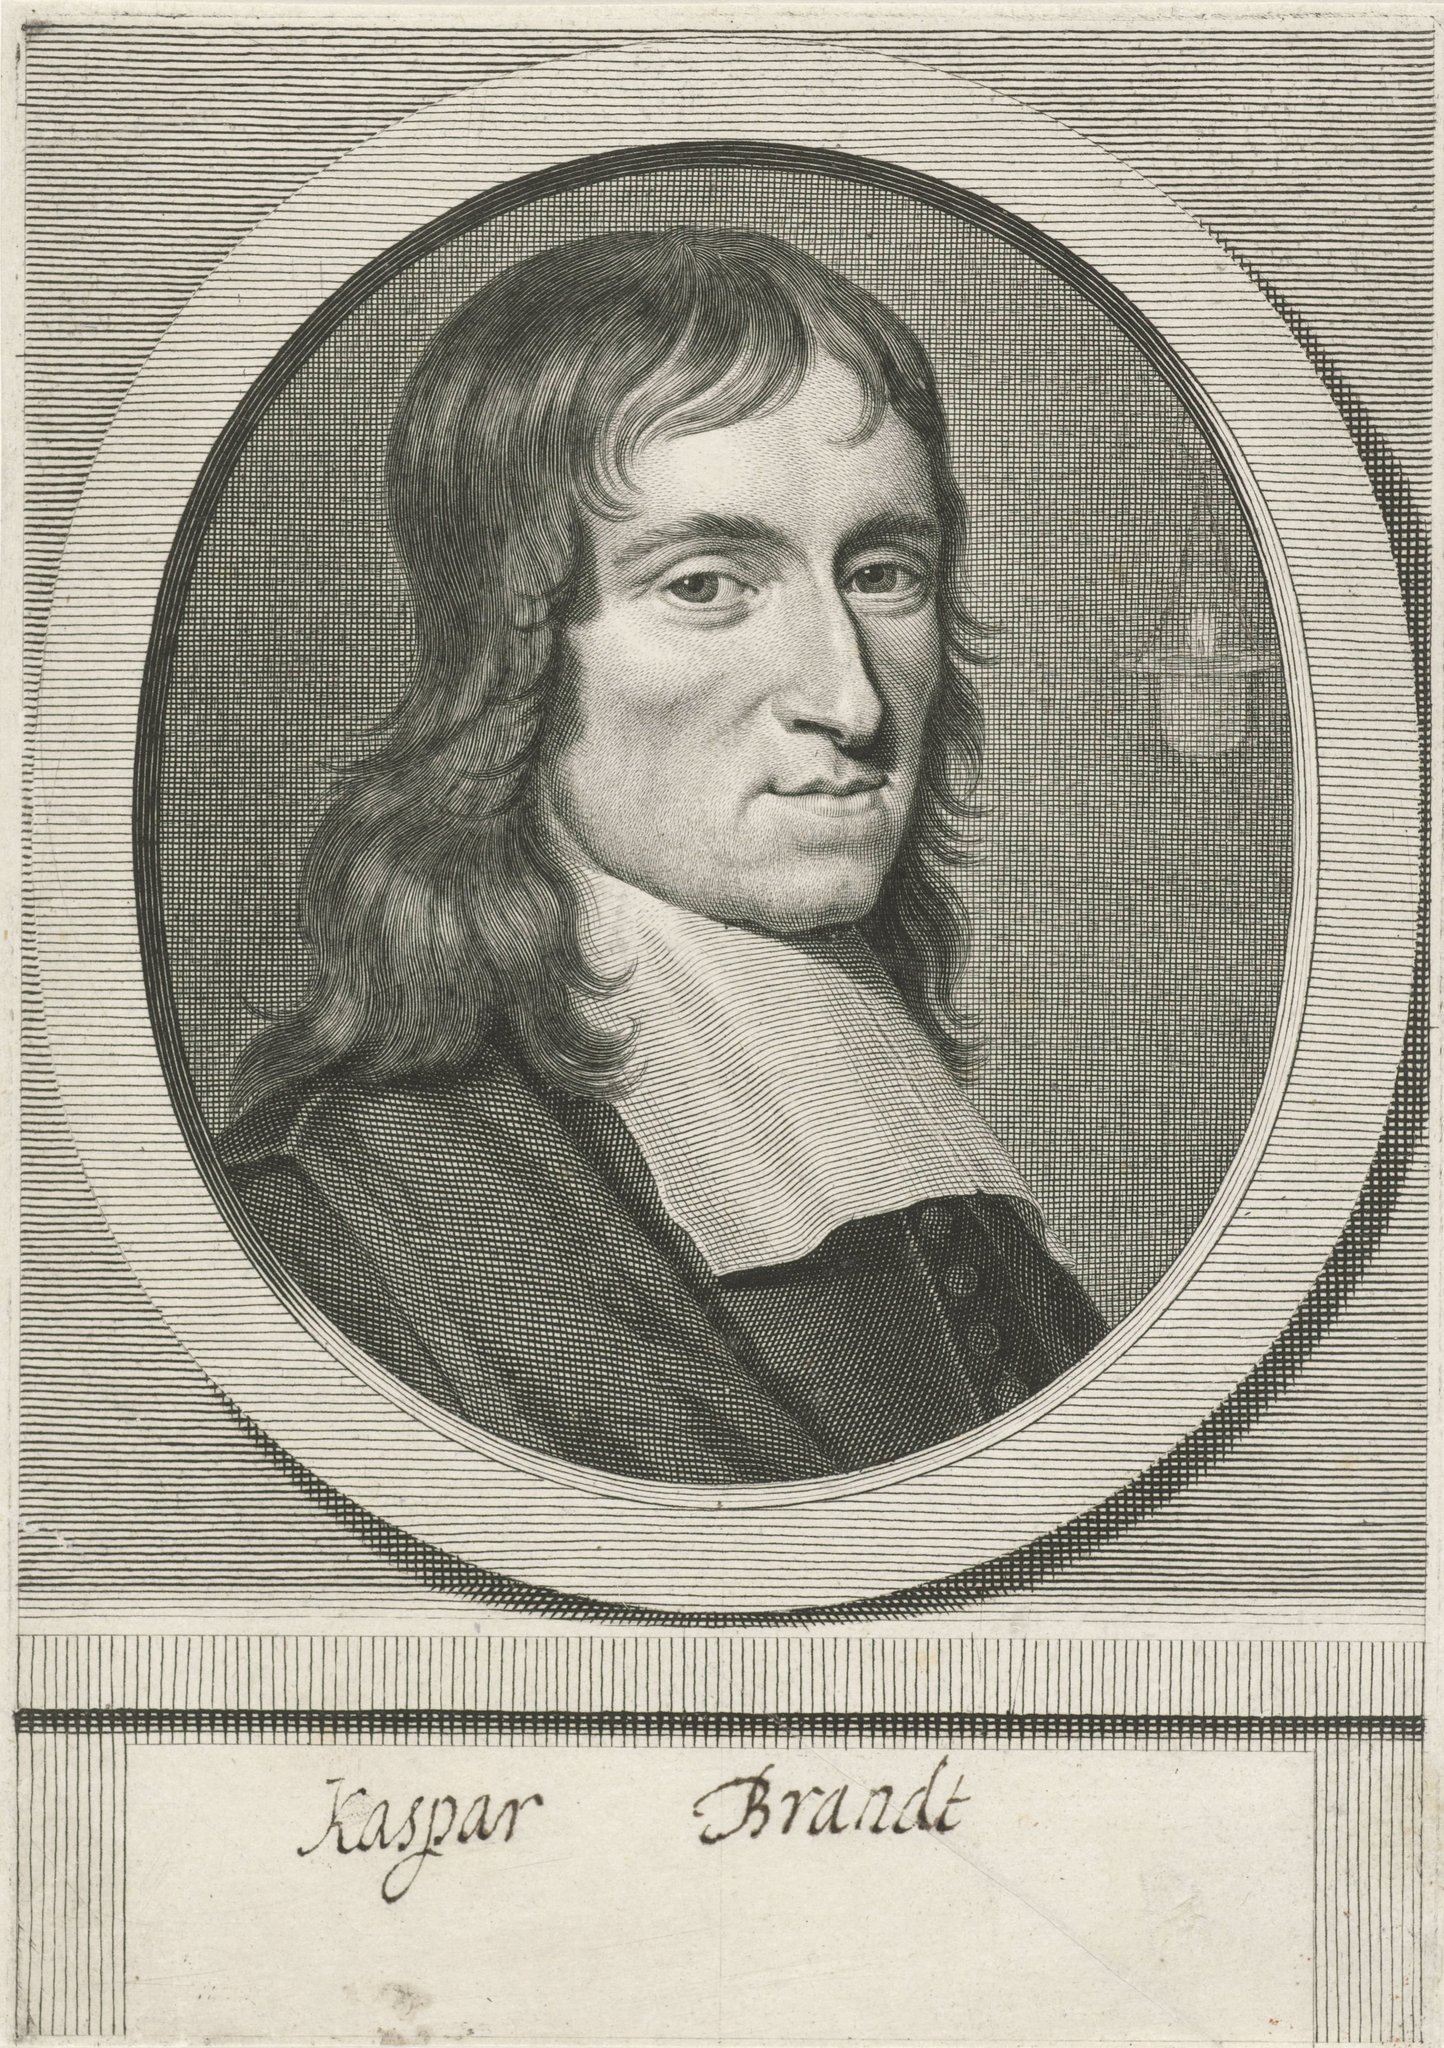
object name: print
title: Portret van Geeraert Brandt (II)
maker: jan van munnickhuysen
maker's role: draughtsman, print maker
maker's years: 1655-1701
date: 1685-1721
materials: paper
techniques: engraving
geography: netherlands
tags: schrijver, predikant, geeraert brandt (ii)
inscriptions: inscription: ‘Kaspar Brandt’, collector's mark: Lugt 240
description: Portret van Geeraert Brandt (II), Remonstrants predikant te Rotterdam.